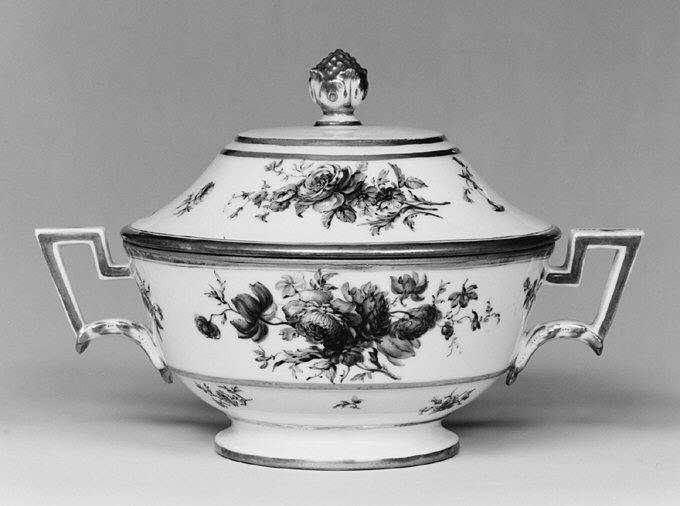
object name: bowl with cover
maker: dihl et guérhard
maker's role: factory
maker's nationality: french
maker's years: 1781-1824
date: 1790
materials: hard paste porcelain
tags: flowers